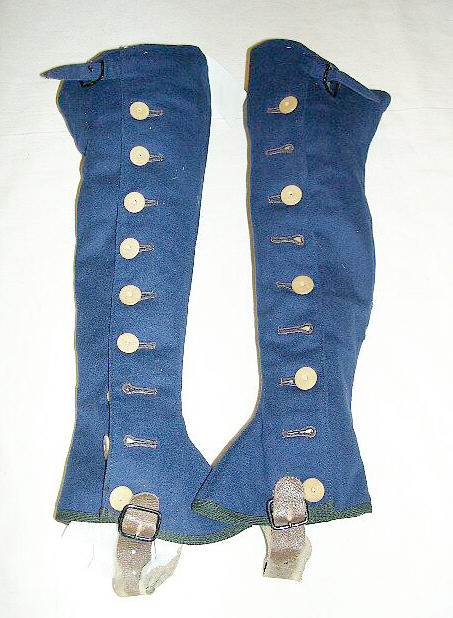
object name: legging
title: Leggings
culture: american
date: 1895-1899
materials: wool